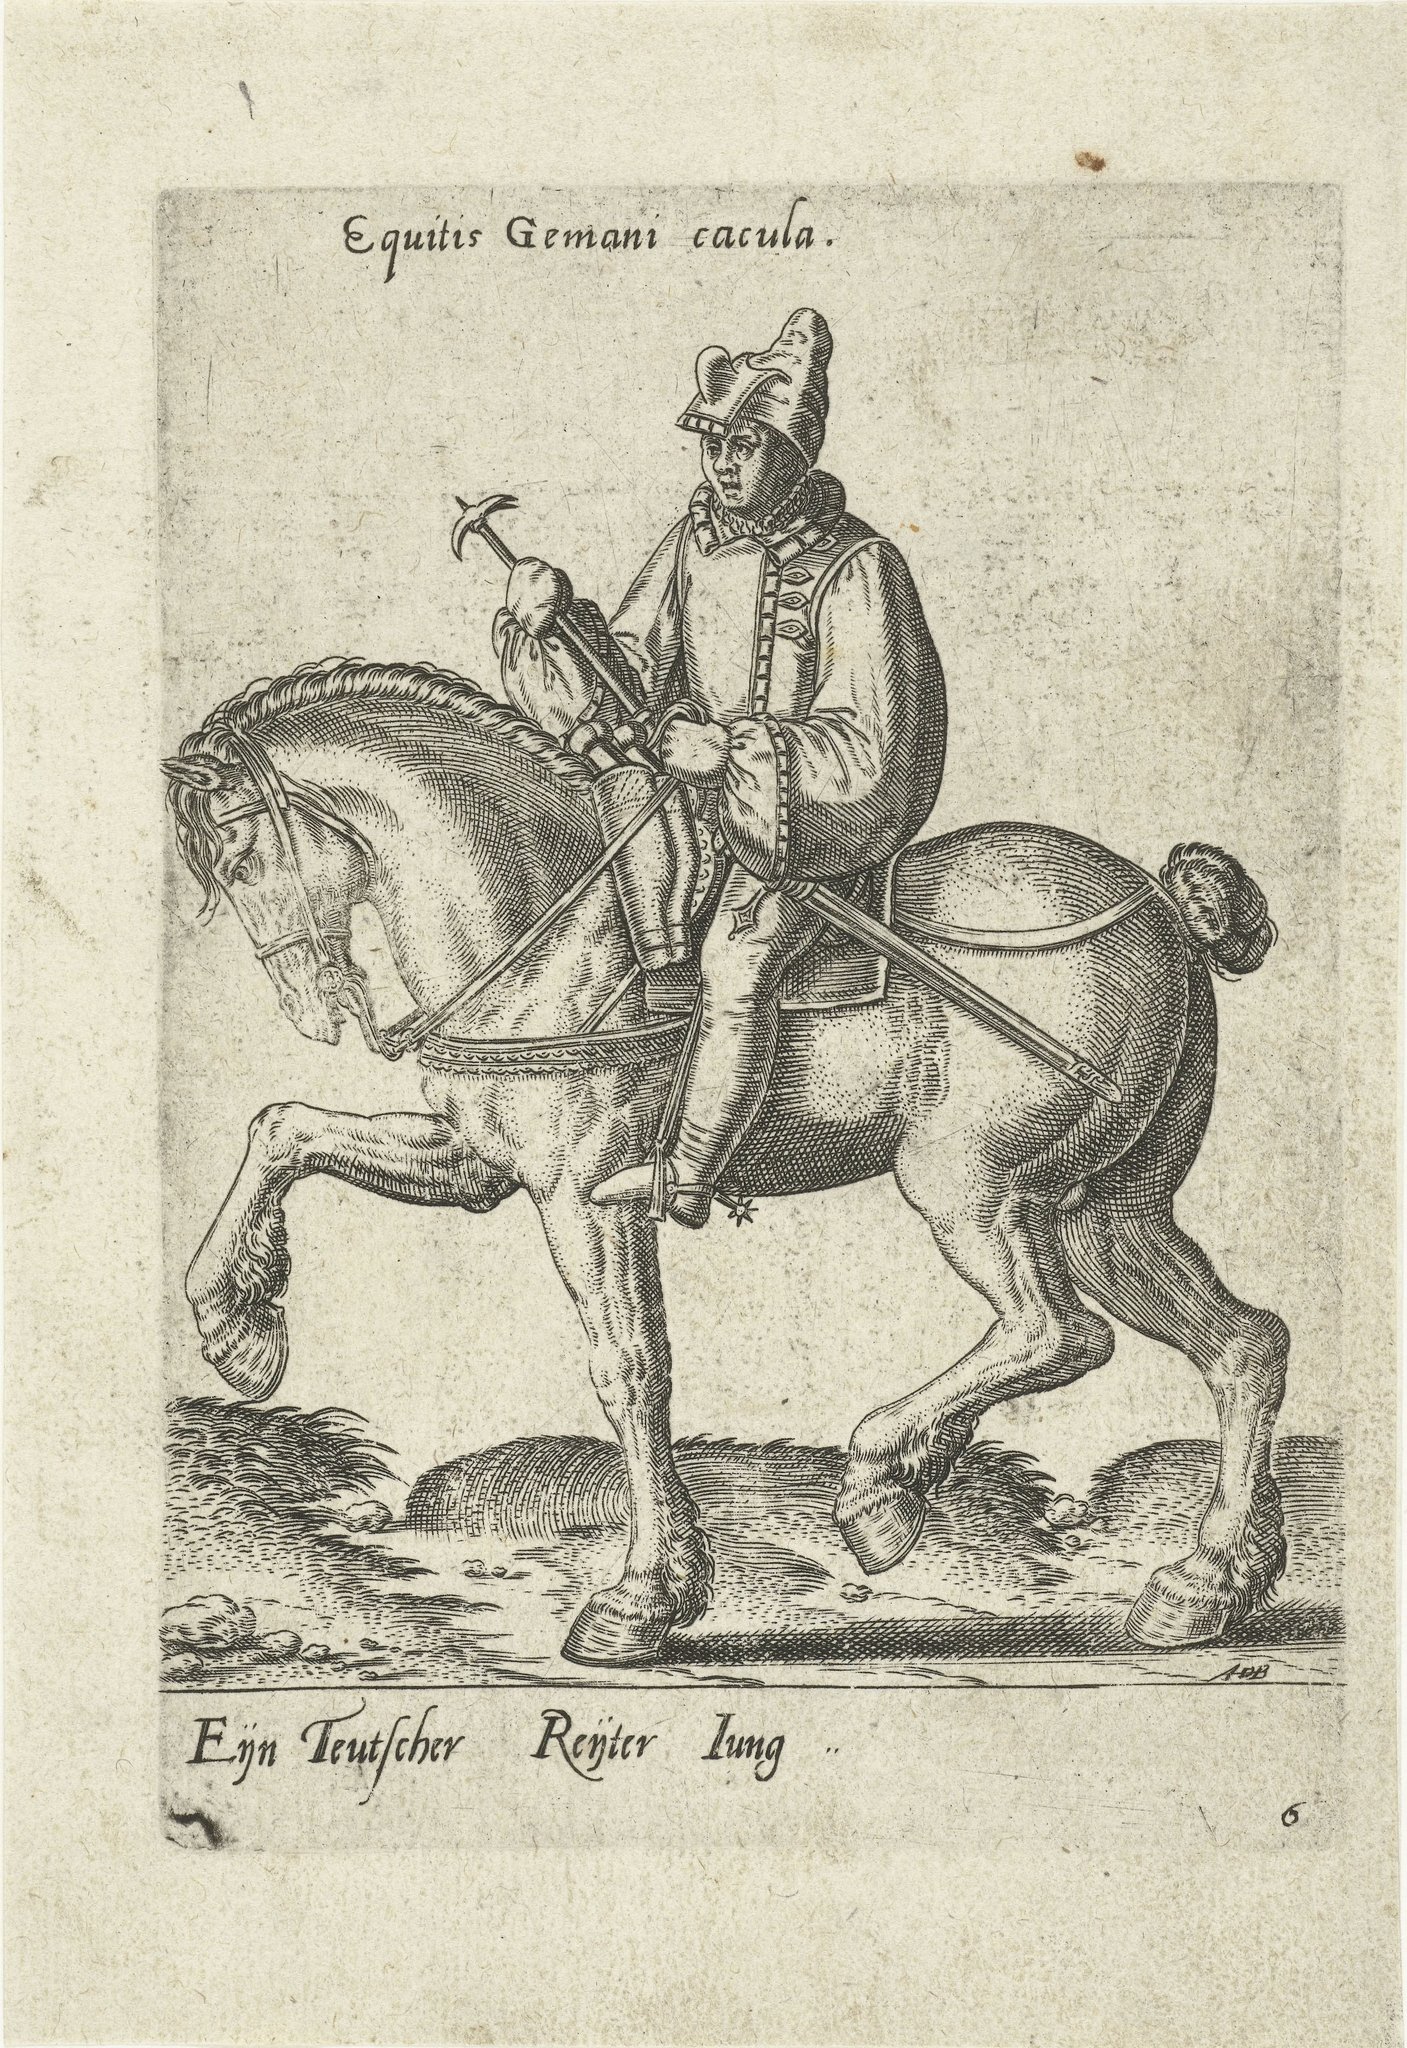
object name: costume print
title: Jonge Duitse ruiter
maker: abraham de bruyn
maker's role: print maker, publisher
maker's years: 1540-1587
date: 1577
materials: paper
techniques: engraving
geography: cologne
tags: warfare; military affairs (+ cavalry, horsemen), folk costume, regional costume, military clothing and other equipment (uniforms, cap, armour, helmet, etc.), europeans: germans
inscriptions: collector's mark: Lugt 2228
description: Prent oorspronkelijk verschenen in 'Equitum descripcio, quomodo equestres copie, nostra hac aetate, in sua armatura, per cunttas, videlicet Europae, Asiae et Affrice, nationes in re militare sese habent nunc primum', Keulen 1577.